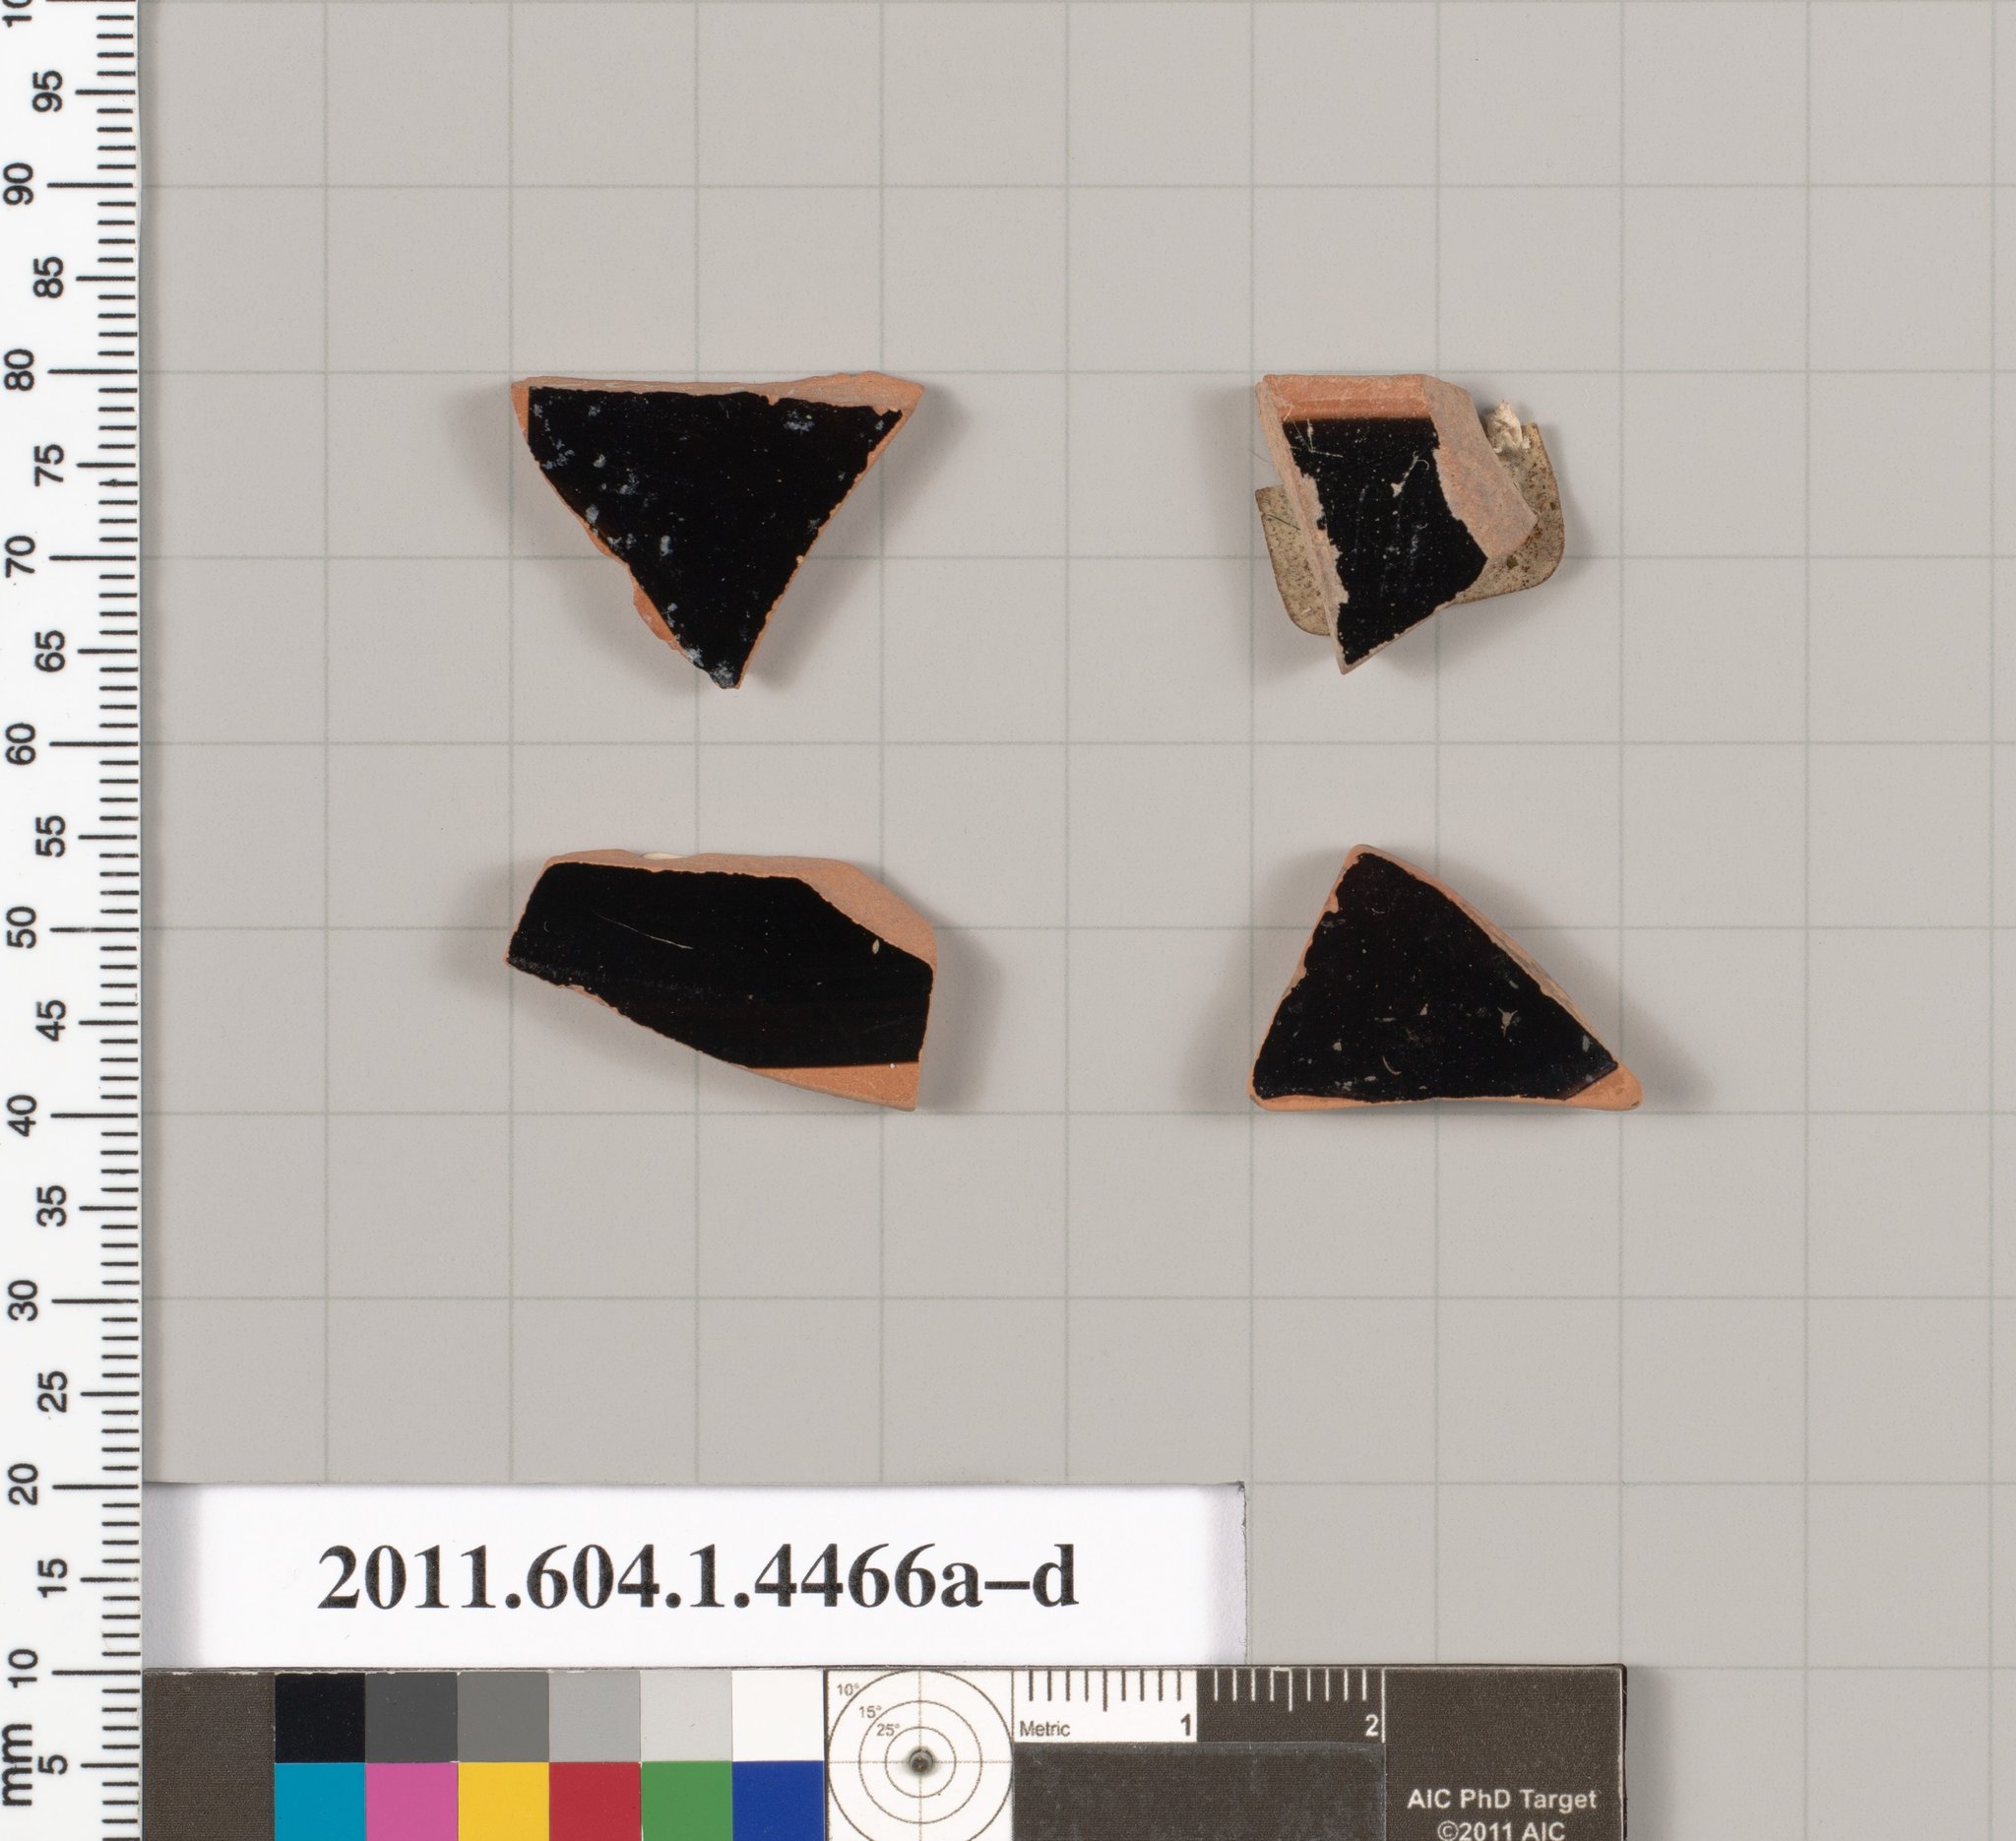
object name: kylix fragment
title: Terracotta fragments of kylikes (drinking cups)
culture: greek, attic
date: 500-451 BCE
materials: terracotta